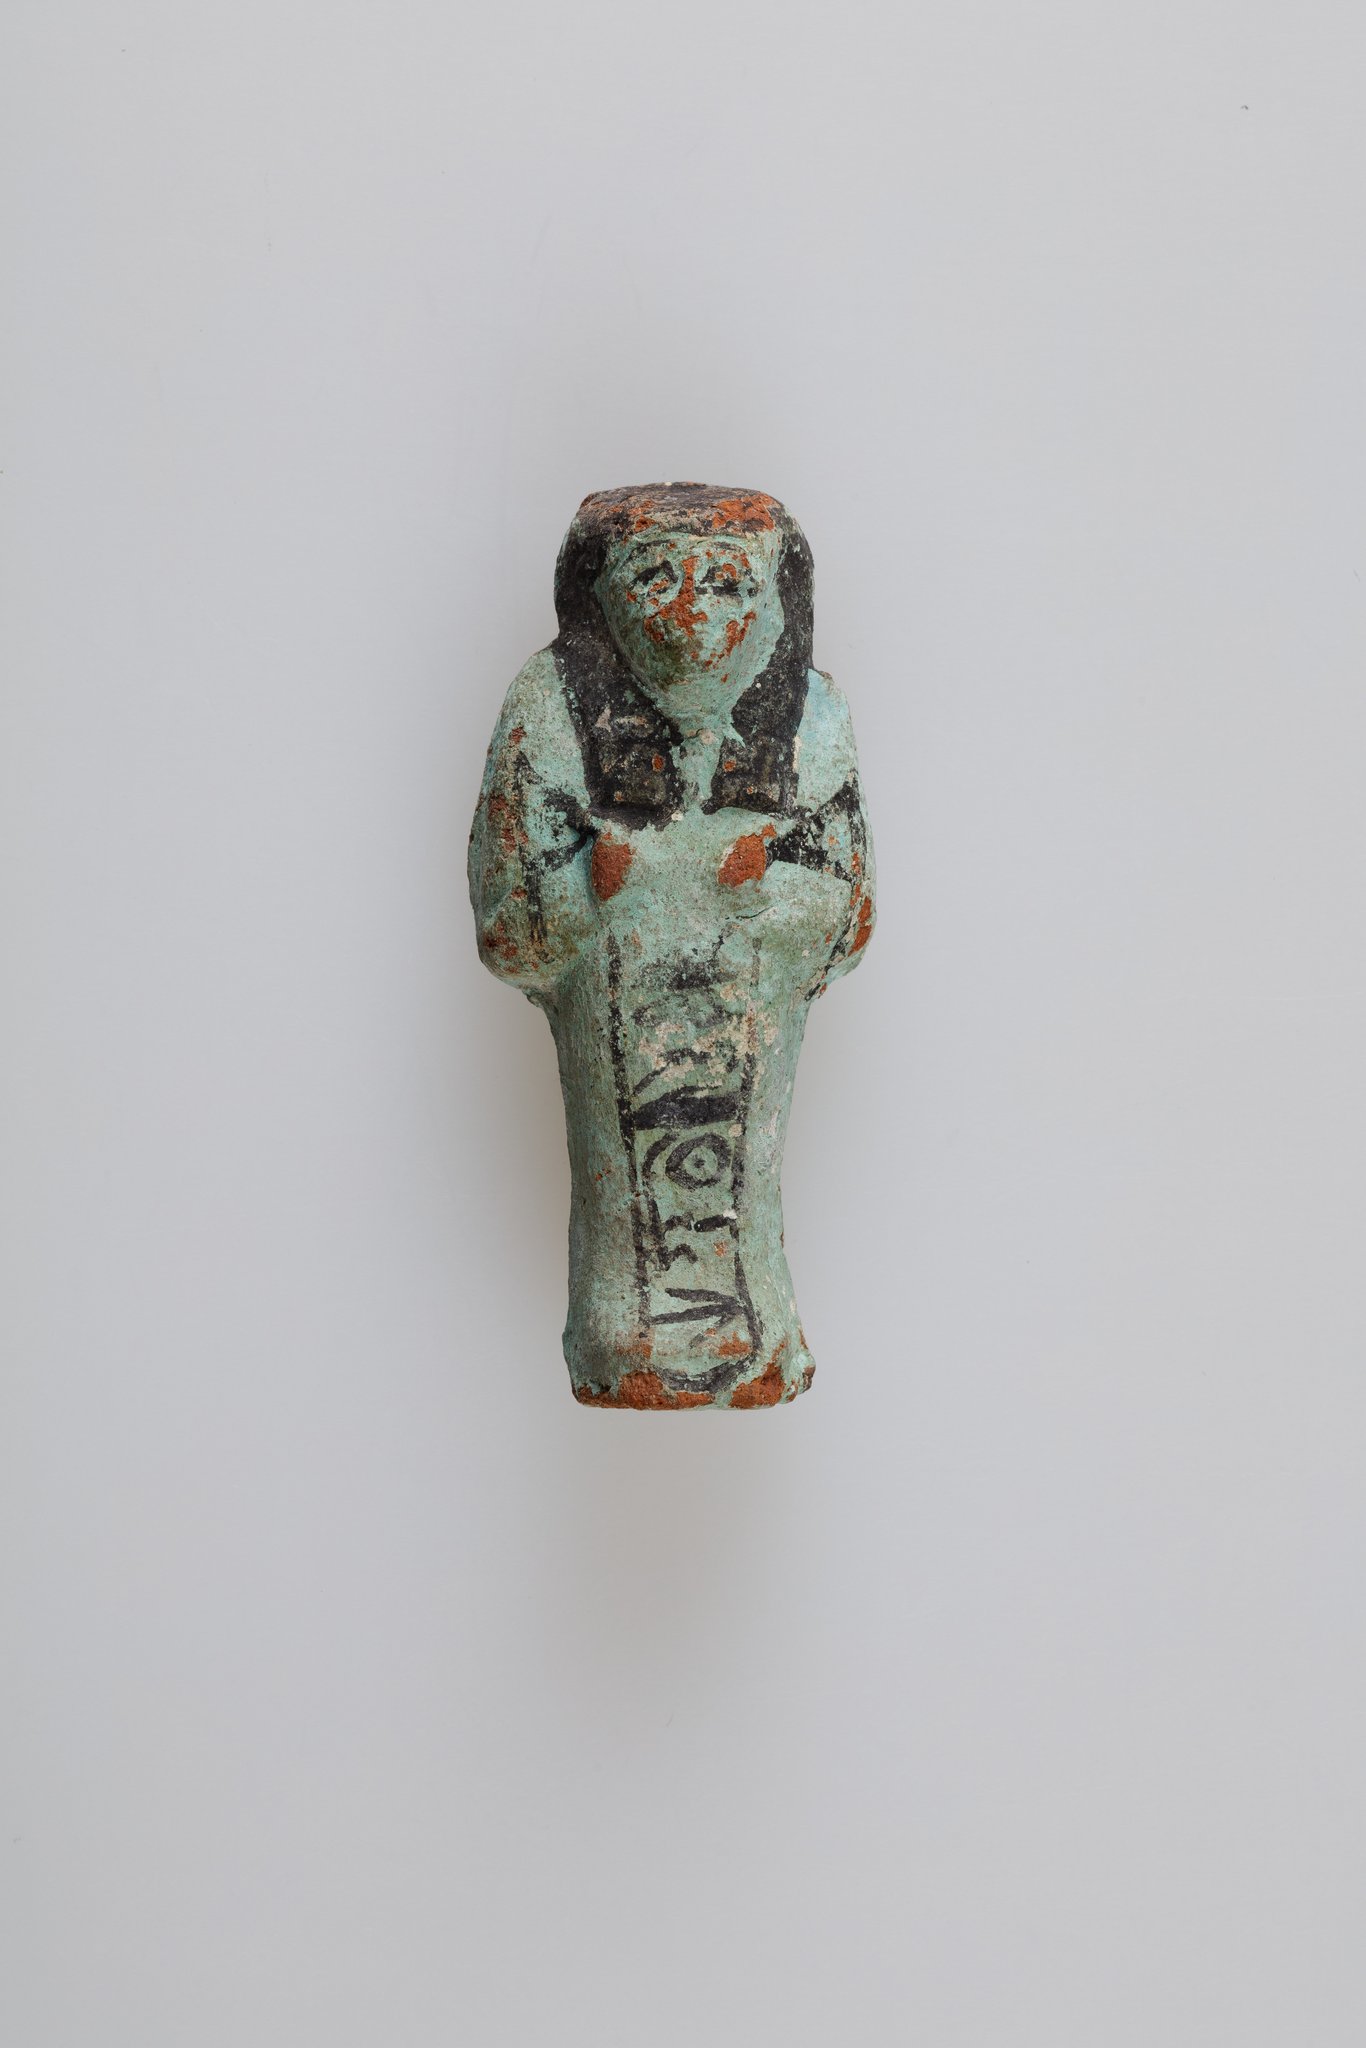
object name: shabti, shedkhonsu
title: Shabti of Shedkhonsu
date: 1070-664 BCE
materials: paint, pottery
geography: egypt